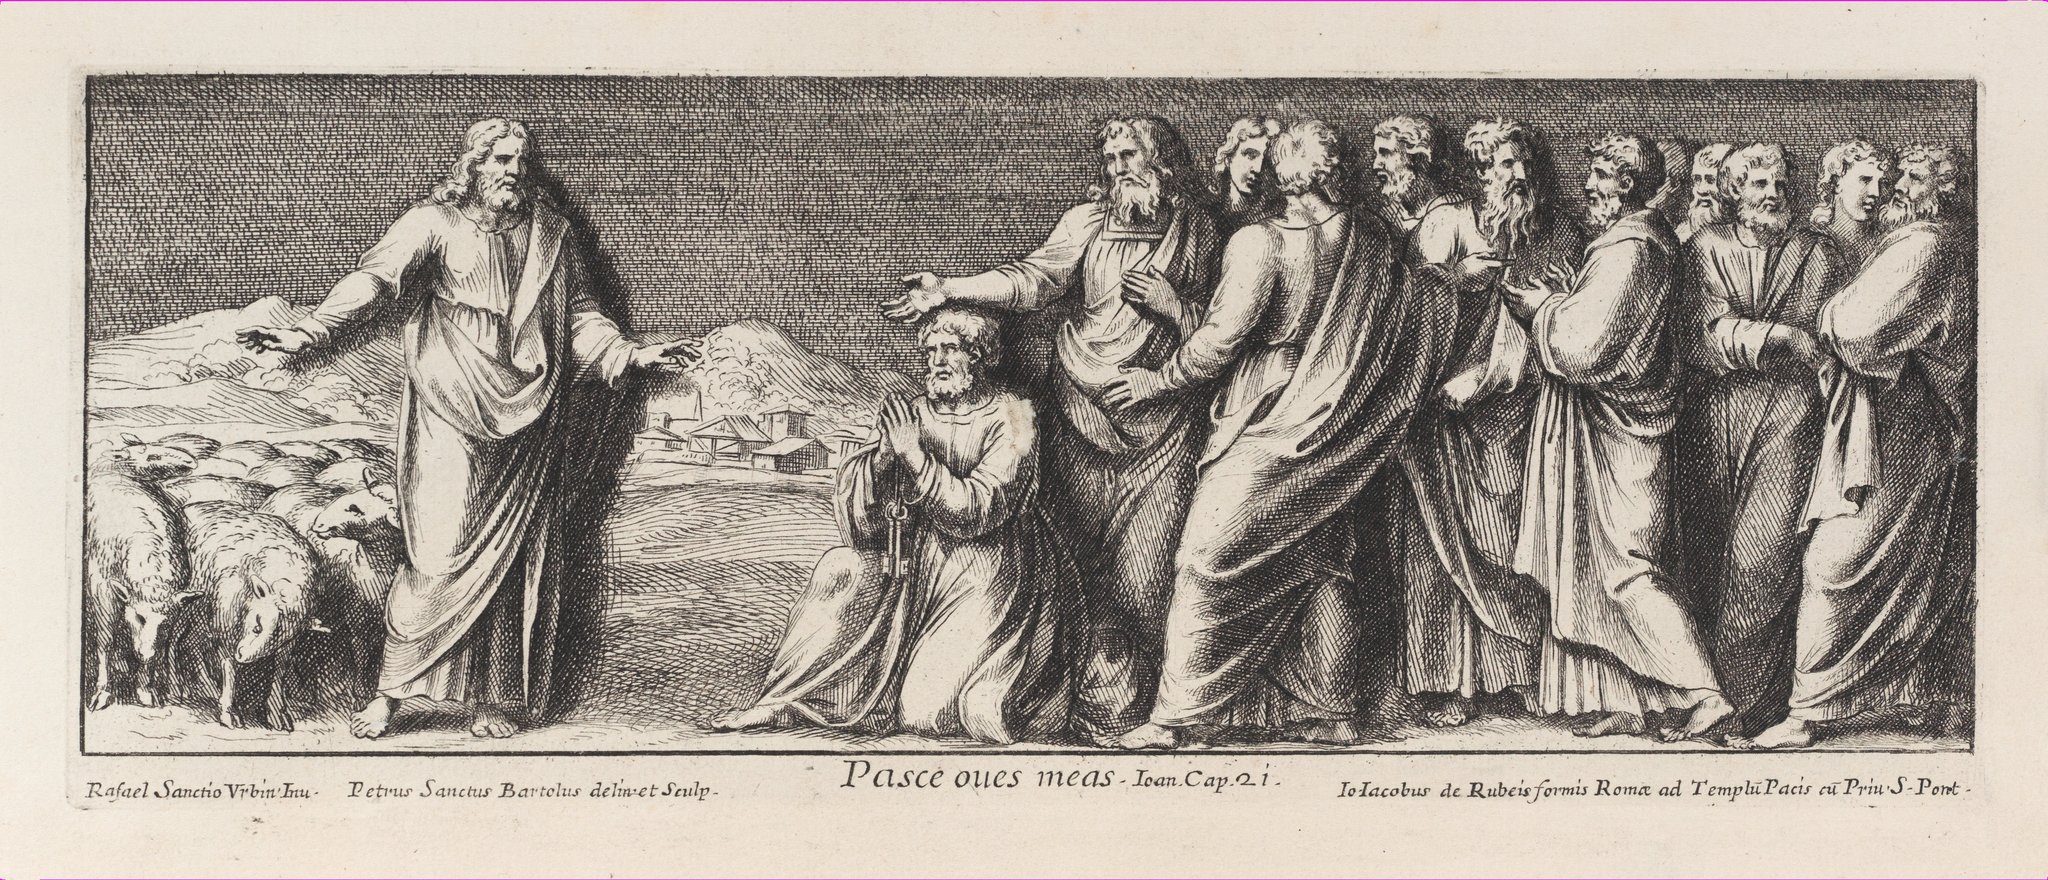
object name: print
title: The naming of Saint Peter as Head of the Church, after Raphael's Stanza dell'incendio del Borgo, from a series of 15 plates, depicting Raphael's works for the Vatican stanze and the Sistine Chapel tapestries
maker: pietro santi bartoli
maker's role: artist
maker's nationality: italian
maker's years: 1615-1700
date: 1650-1670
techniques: etching